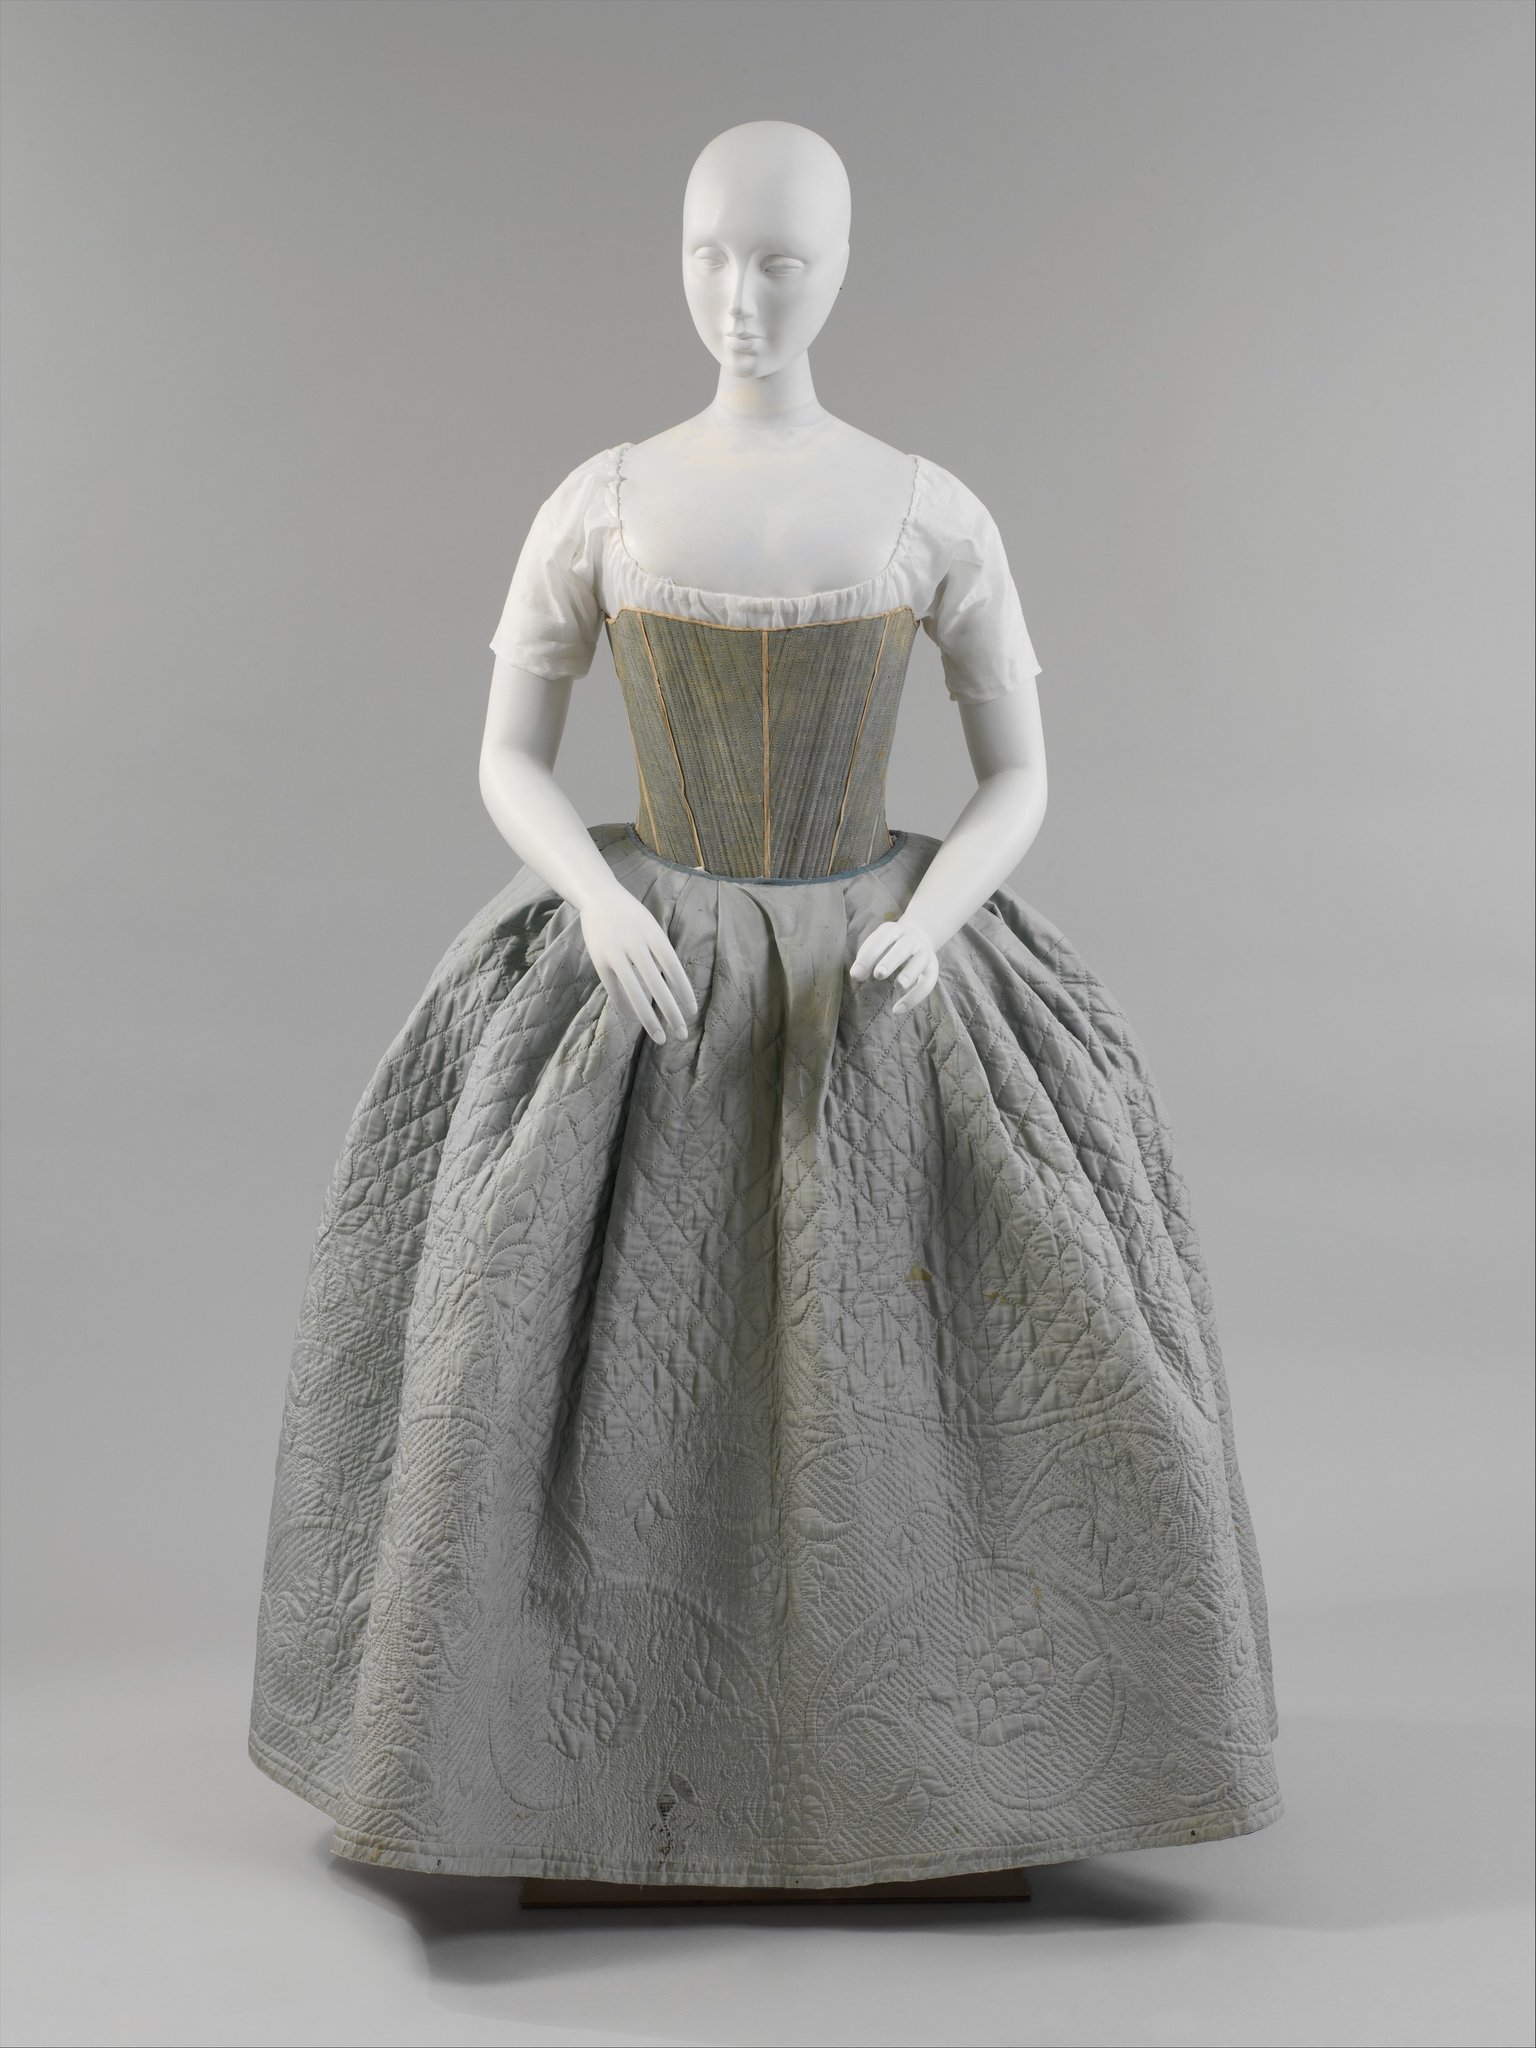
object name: petticoat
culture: american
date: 1751-1800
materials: silk